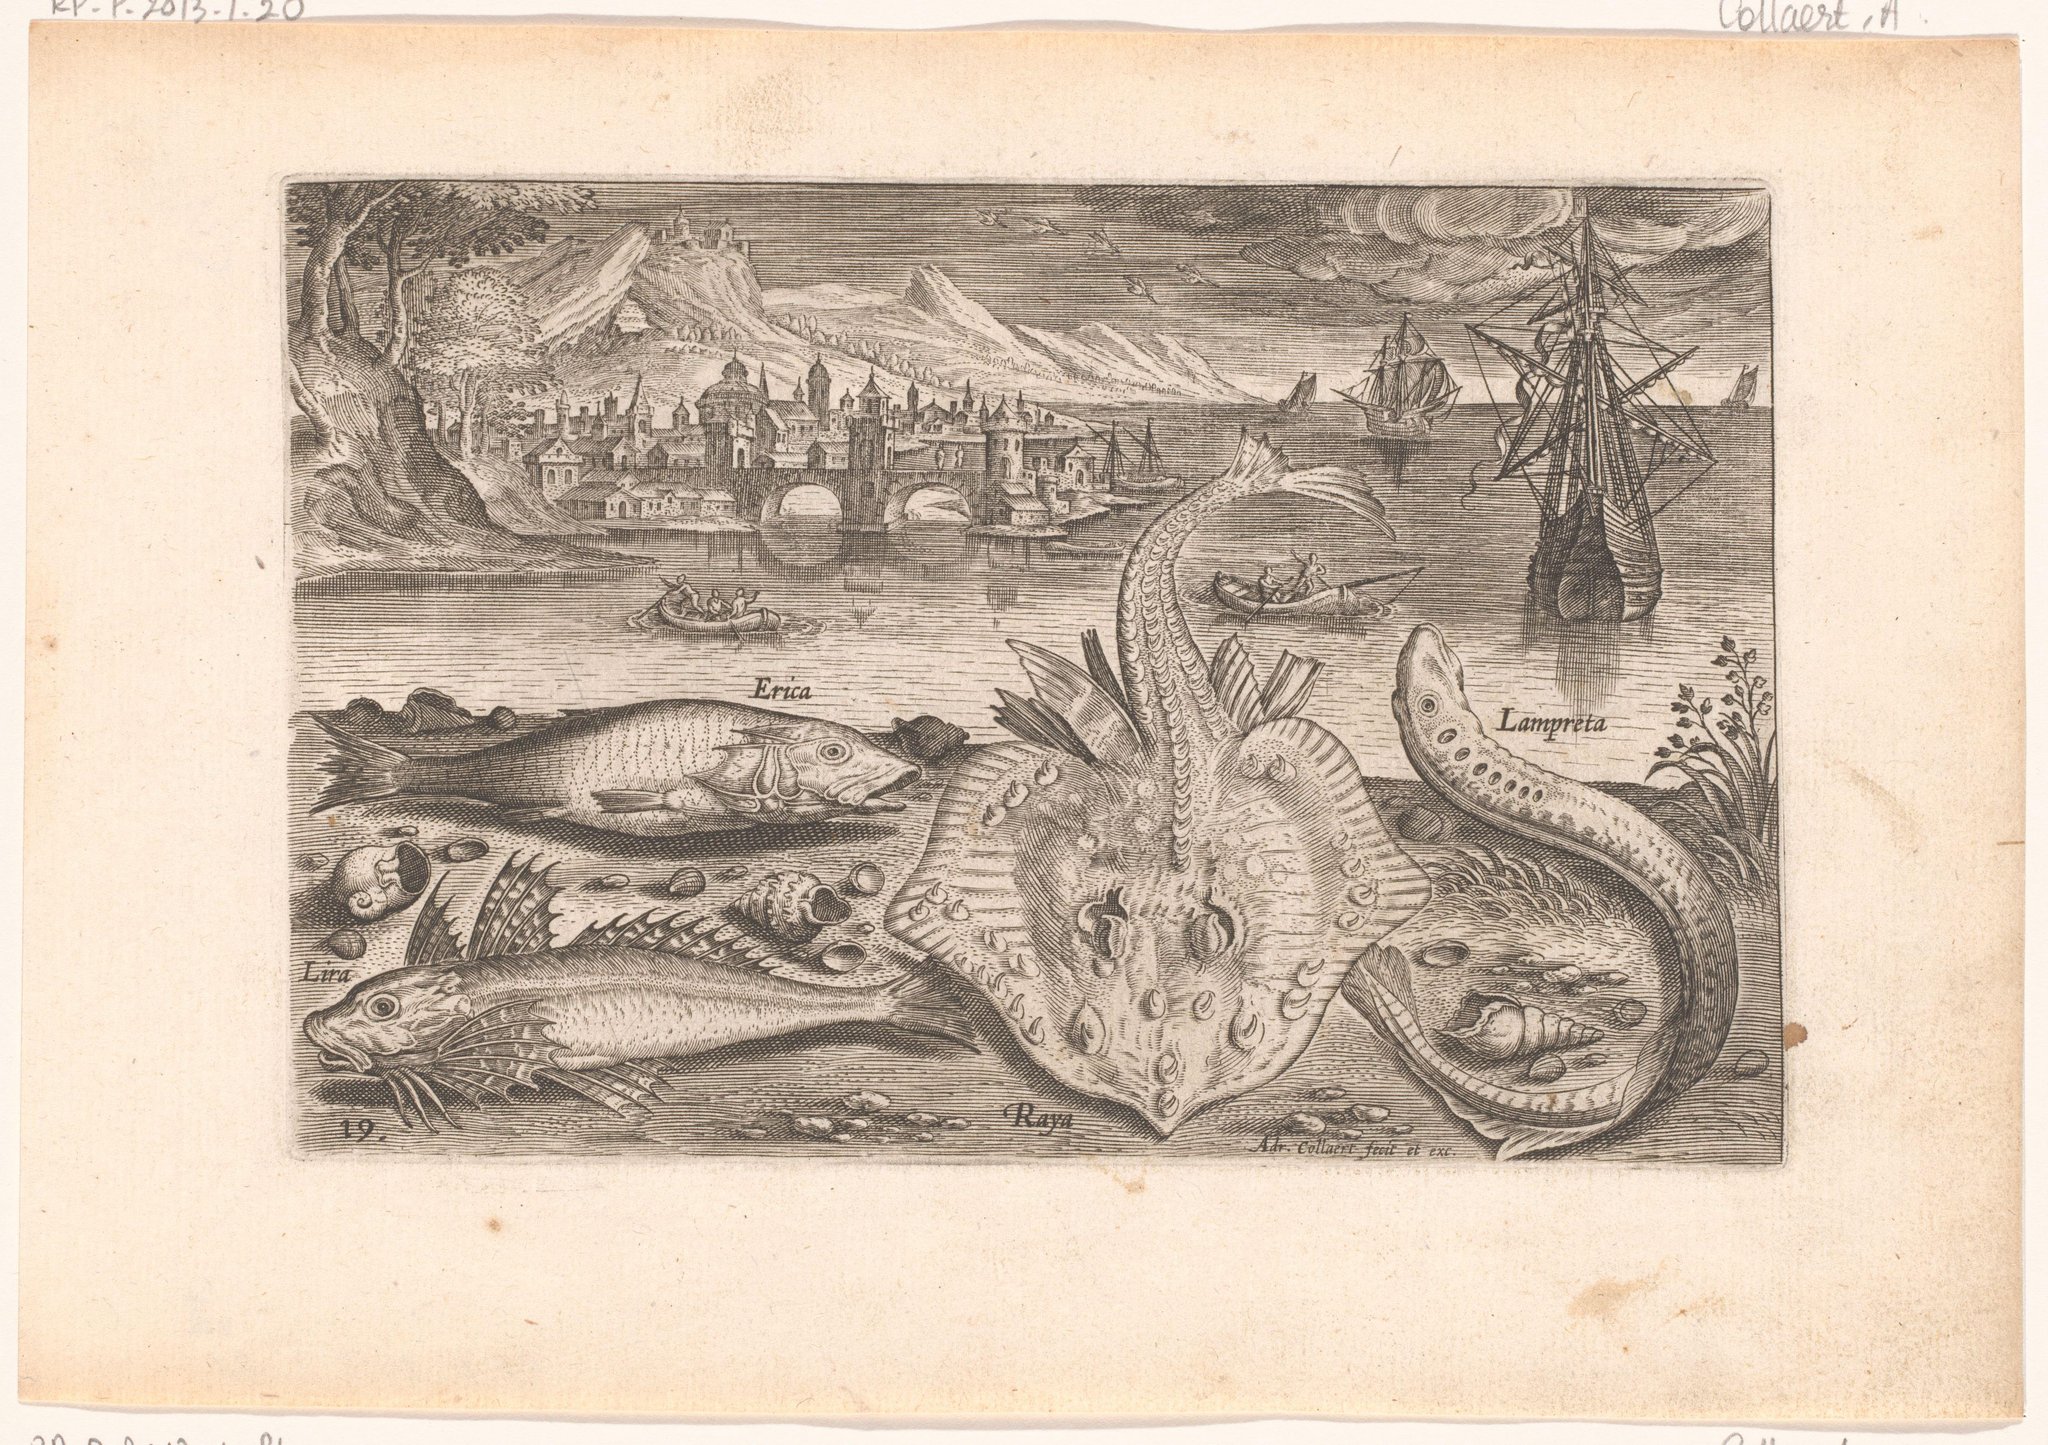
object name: print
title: Vissen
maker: adriaen collaert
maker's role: draughtsman, print maker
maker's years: 1560-1618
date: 1598-1618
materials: paper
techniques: engraving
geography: antwerp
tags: sea (seascape), cartilaginous fishes: ray, bony fishes, eels: lamprey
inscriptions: collector's mark: Lugt 2228, number: ‘54/17’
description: Een rog, een zeeprik, een vliegende vis en een onbekende vis liggen samen met wat schelpen aangespoeld op het strand. Op de achtergrond een zee met enkele schepen. De prent maakt deel uit van een serie met vissen als onderwerp.